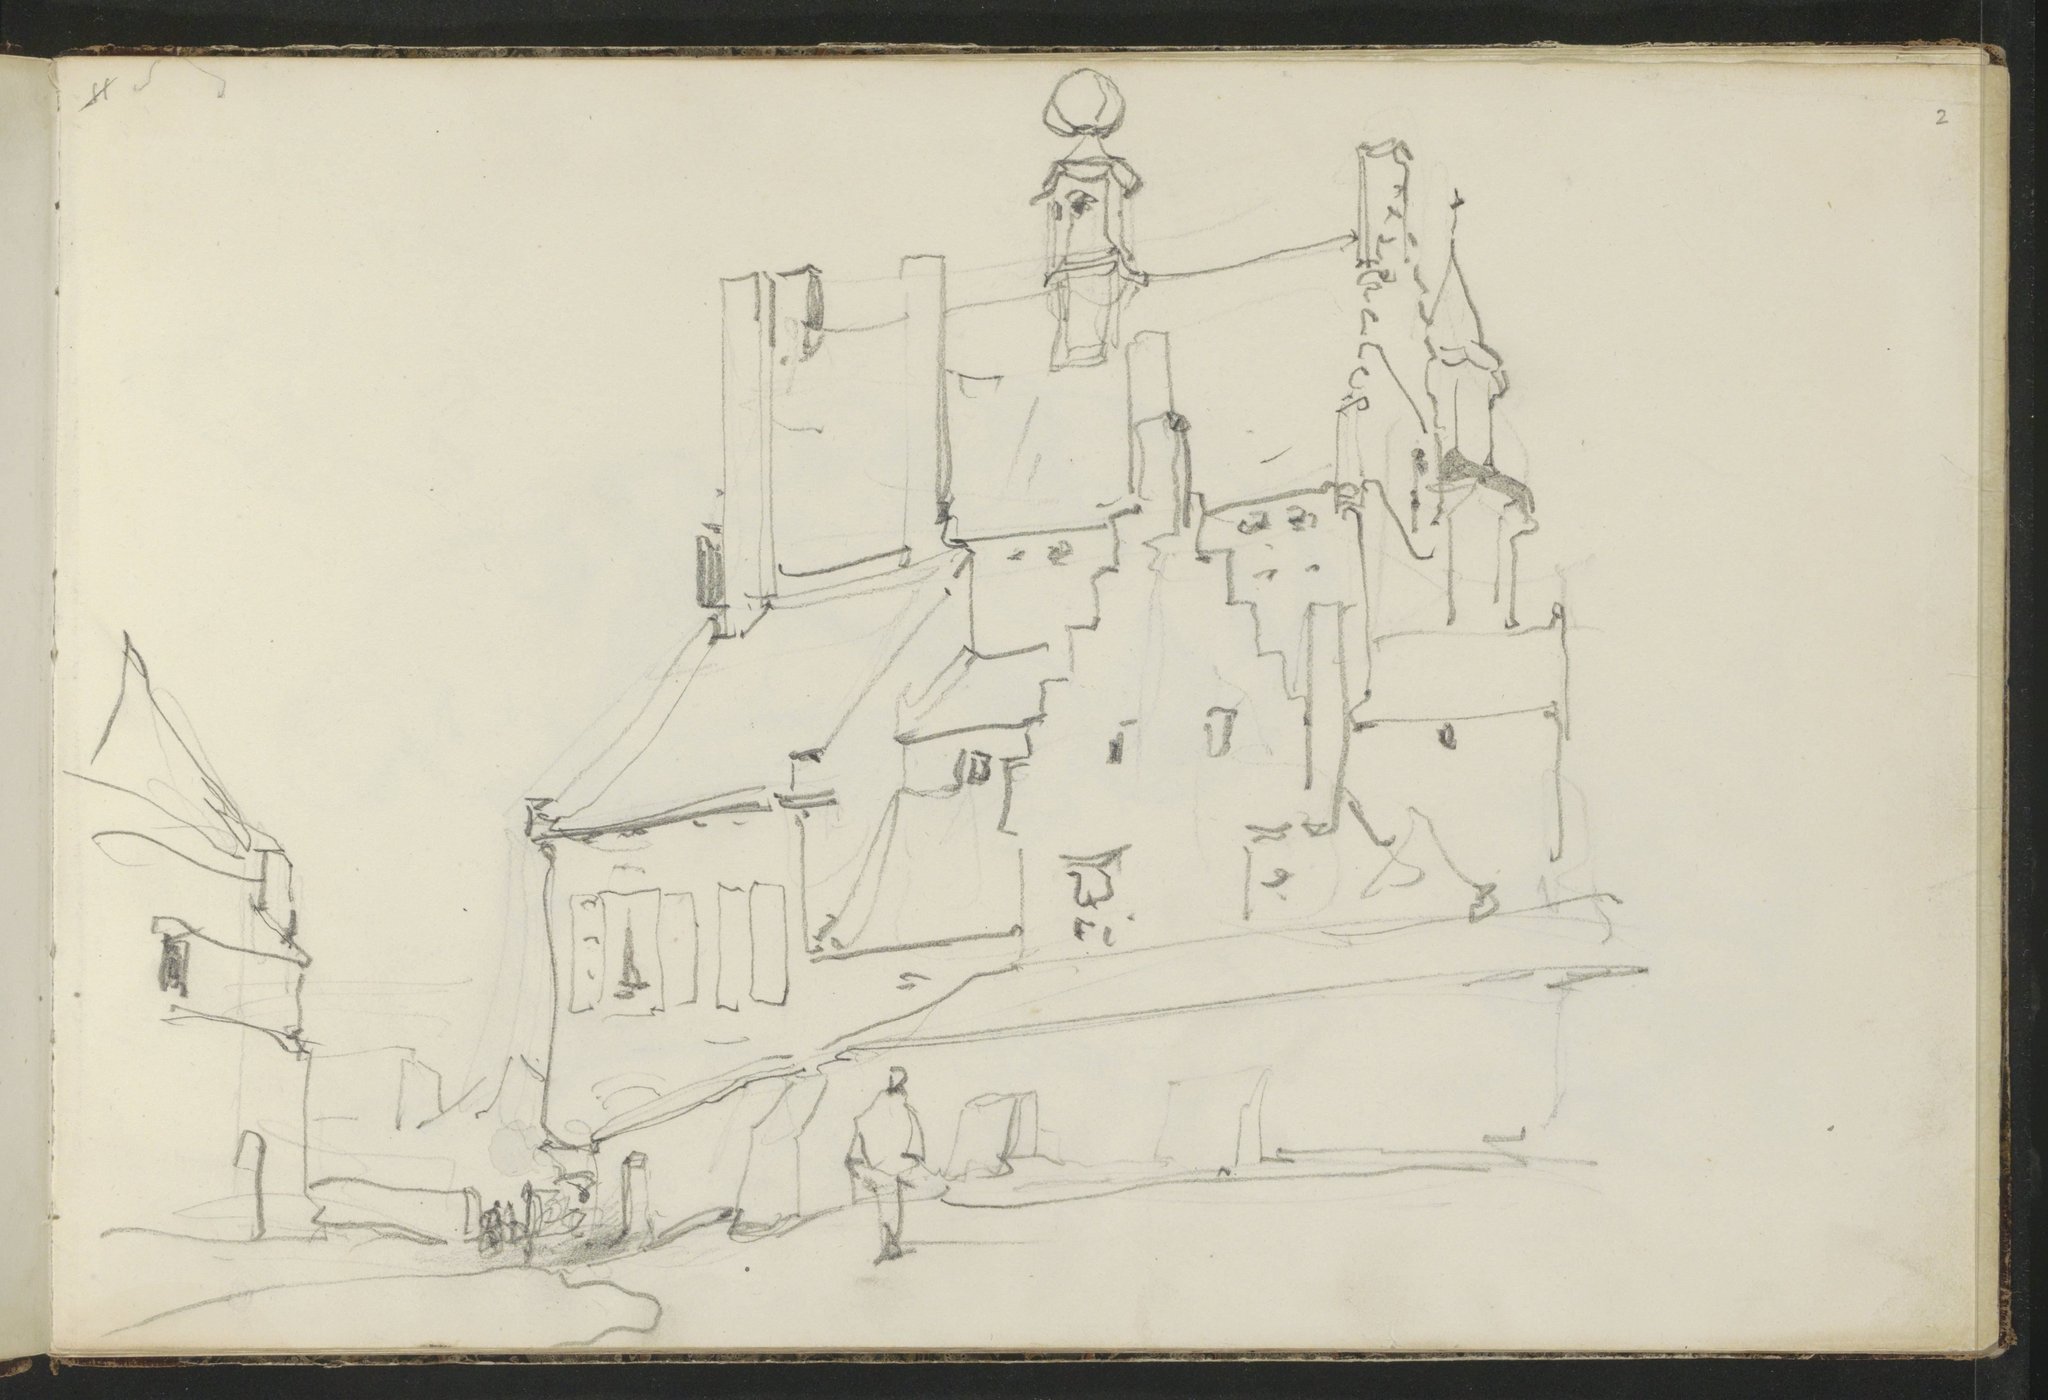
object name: sketchbook leaf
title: Gebouw met trapgevels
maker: johannes bosboom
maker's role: draughtsman, painter, print maker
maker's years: 1817-1891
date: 1827-1891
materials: paper, pencil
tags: street (+ city(-scape) with figures, staffage)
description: In een straat naast het gebouw lopen figuren. Blad 2 recto uit een schetsboek met 11 bladen.